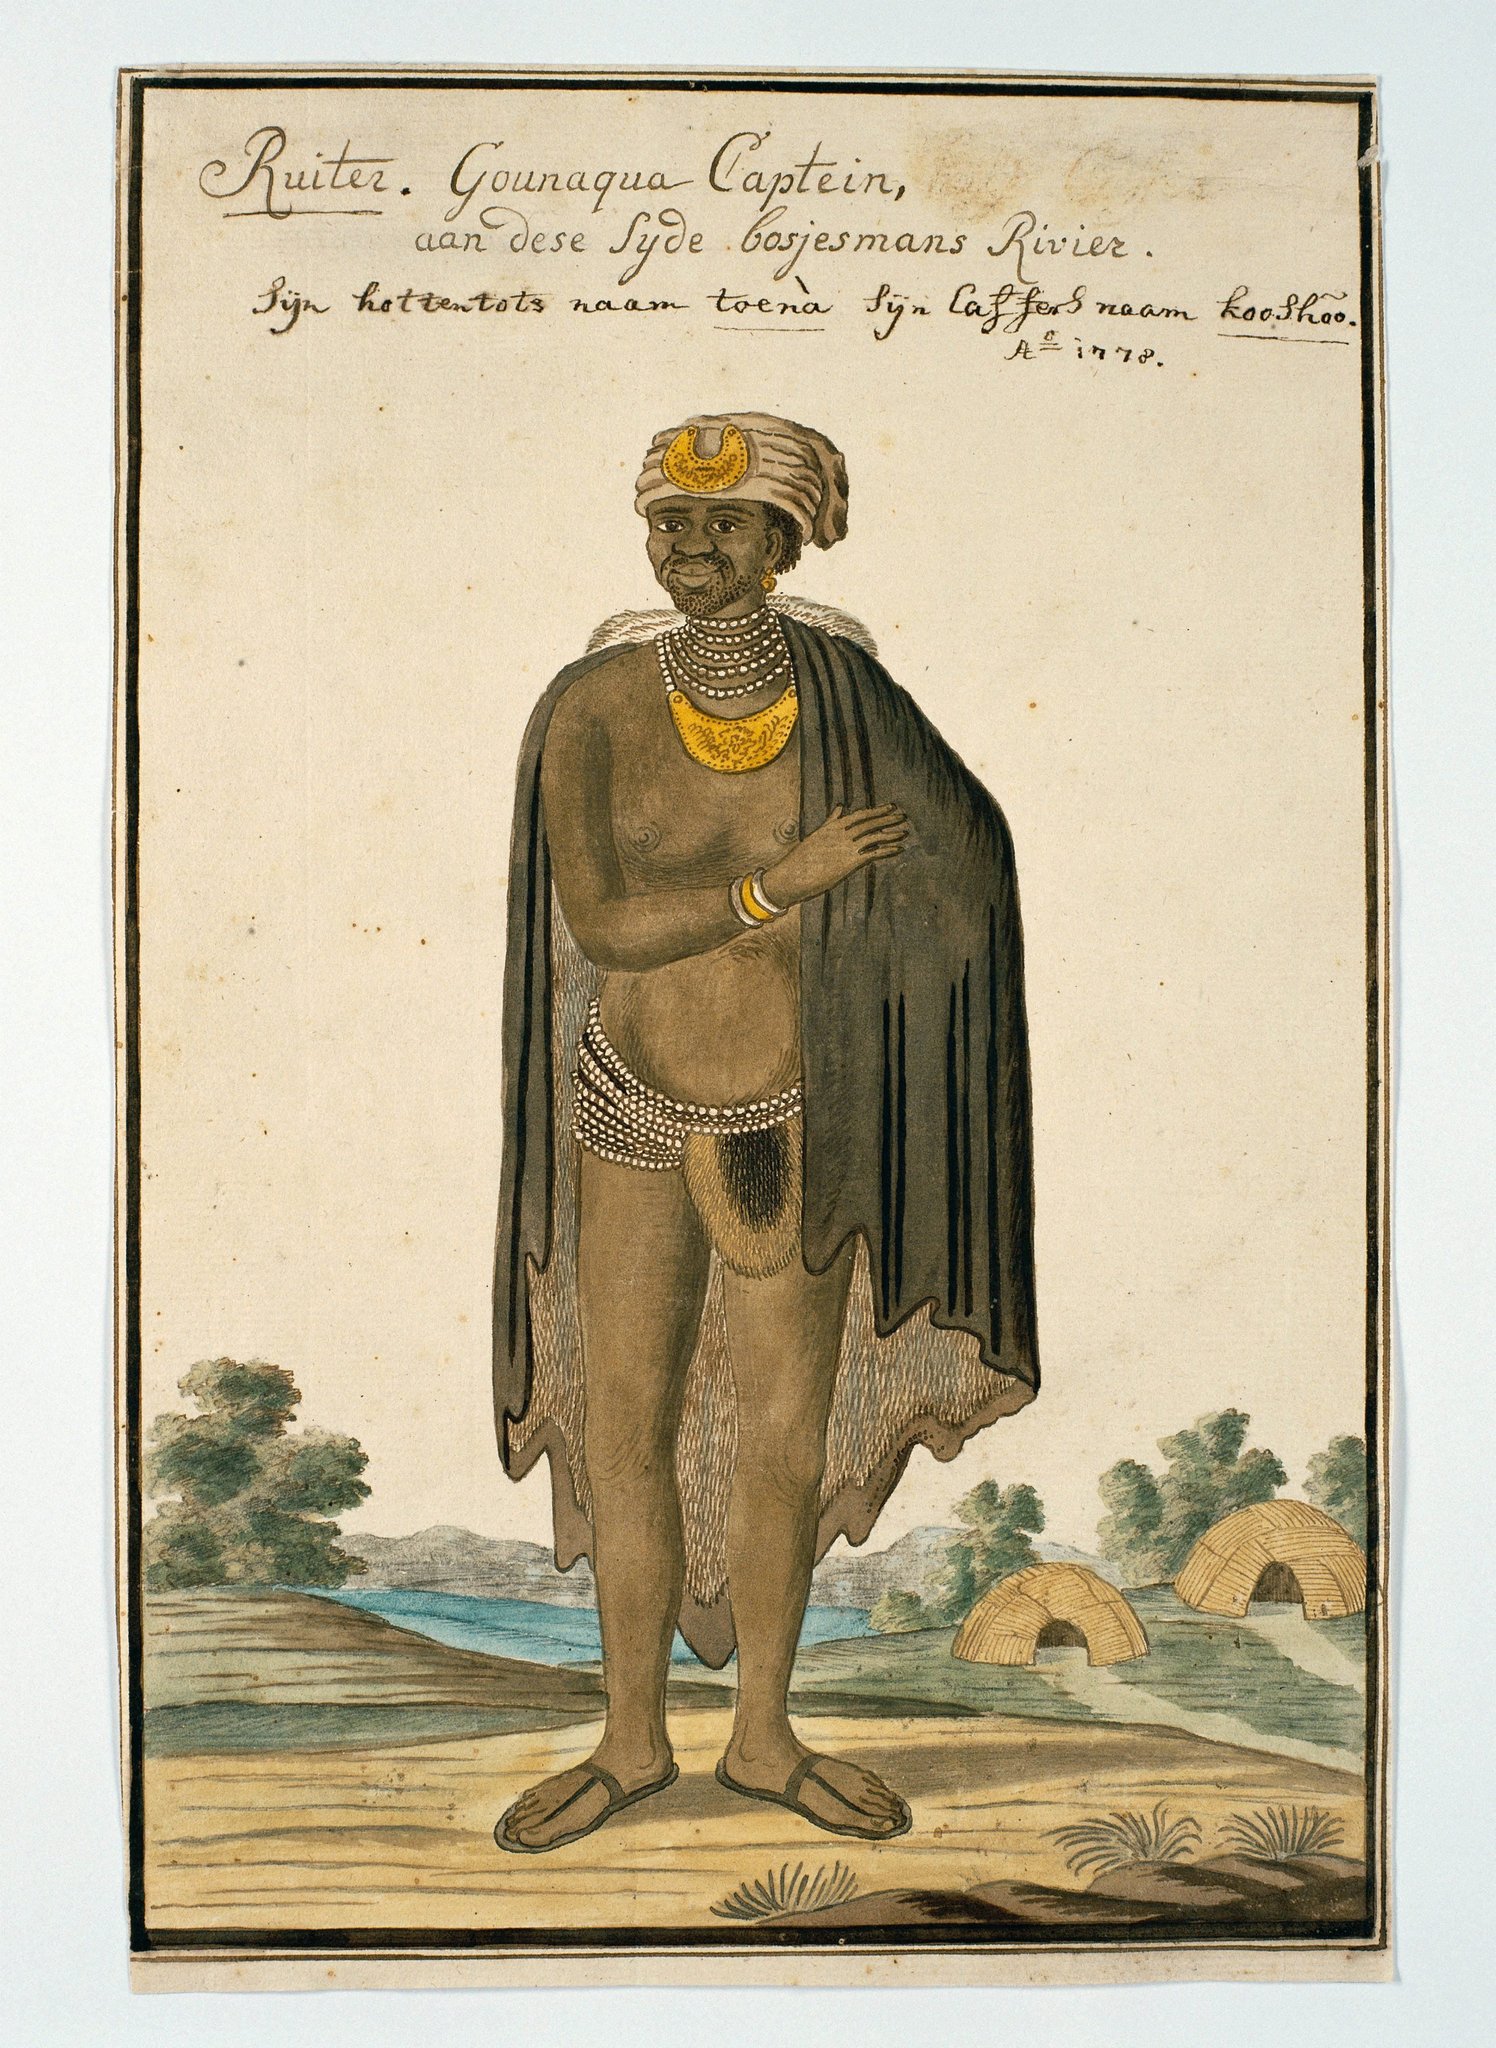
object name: album leaf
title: The Gonaqua chieftain, Ruiter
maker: robert jacob gordon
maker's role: draughtsman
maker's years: 1743-1795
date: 1701-1778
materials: paint, paper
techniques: brush, pen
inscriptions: date and inscription: ‘Ruiter [onderstreept]. Gounaqua Captein, / aan dese Sijde bosjesmans Rivier. / Sijn hottentots naam toenà [onderstreept] Sijn Caffers naam KooShoo. [onderstreept] / Aº 1778.’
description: Een Khoi vrouw en het Khoi opperhoofd Ruyter Een vrouw, die in dienst is bij de Kaapse boer Frederik Potgieter, en een Khoi opperhoofd met zijn van de VOC ontvangen ringkragen.